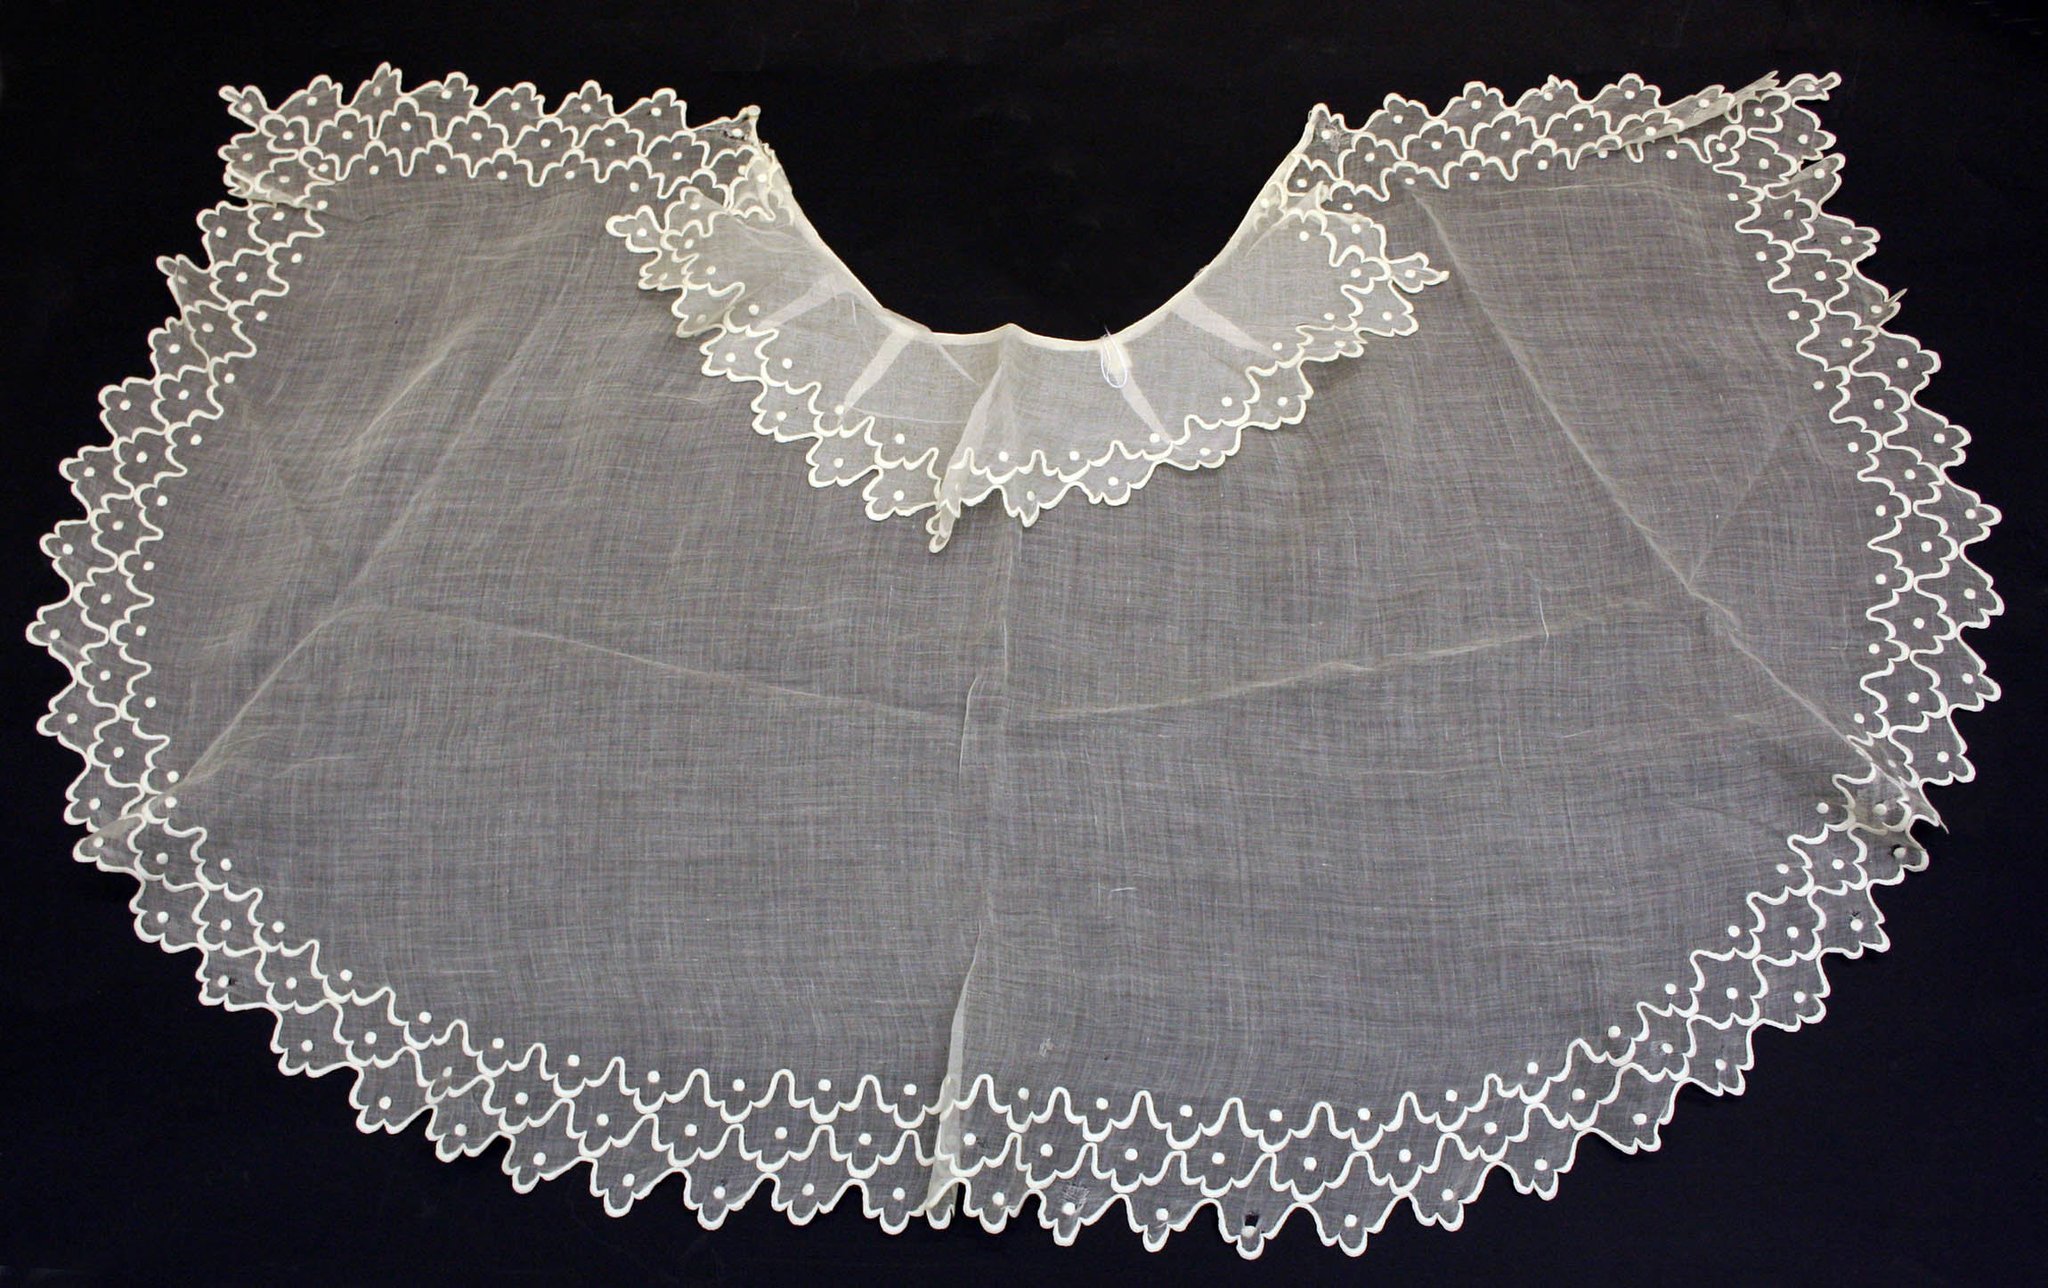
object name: collar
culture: british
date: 1830-1839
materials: cotton